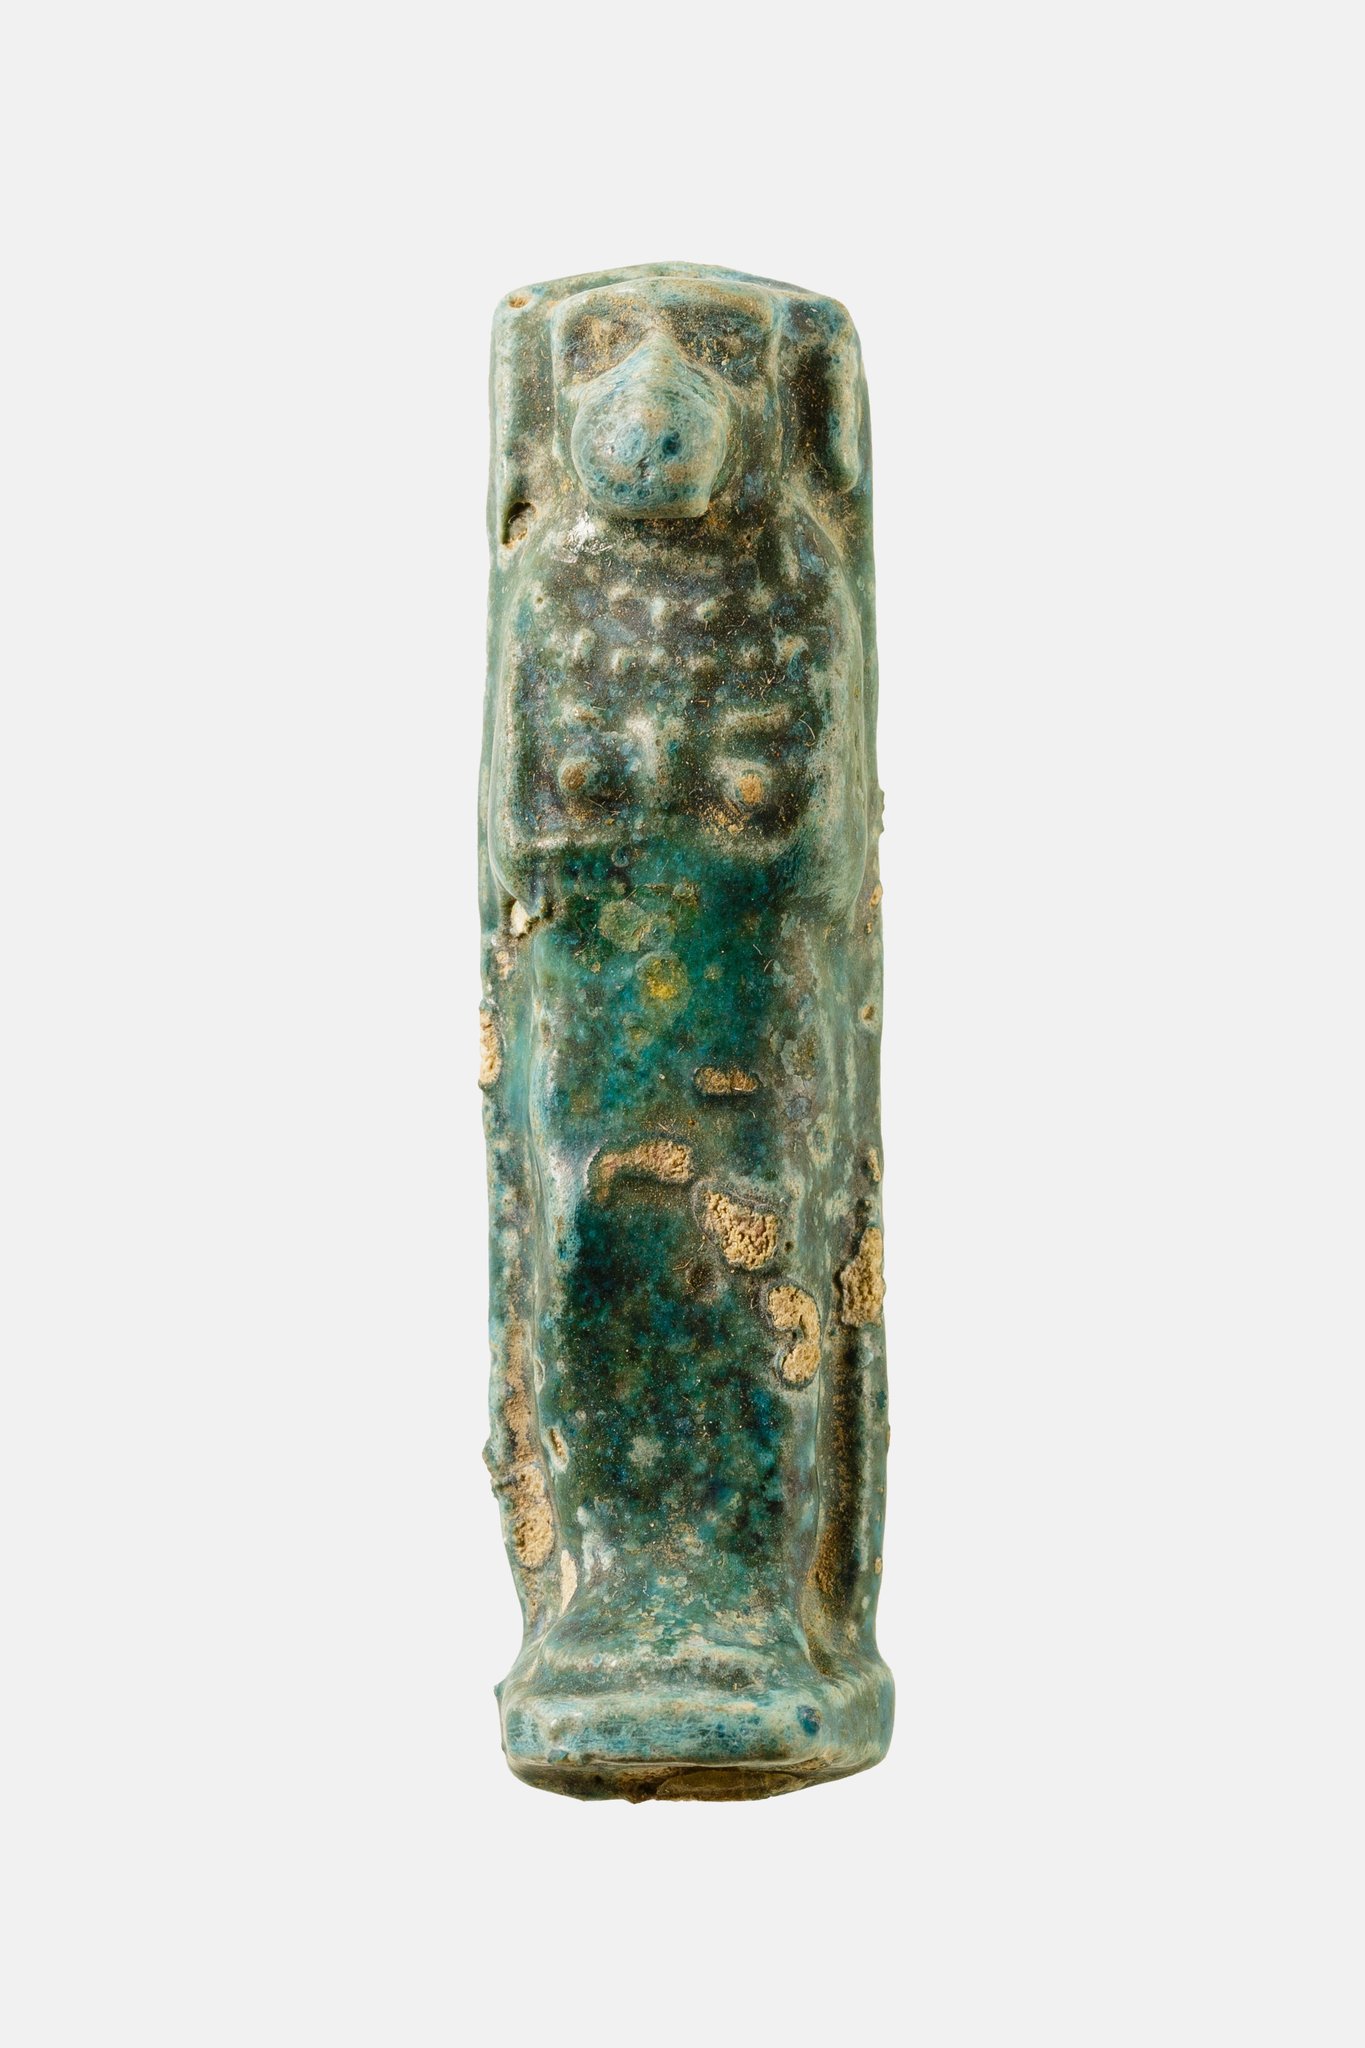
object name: amulet, son of horus, monkey headed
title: Amulet depicting one of the four sons of Horus, Hapy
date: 1070-525 BCE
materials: faience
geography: egypt